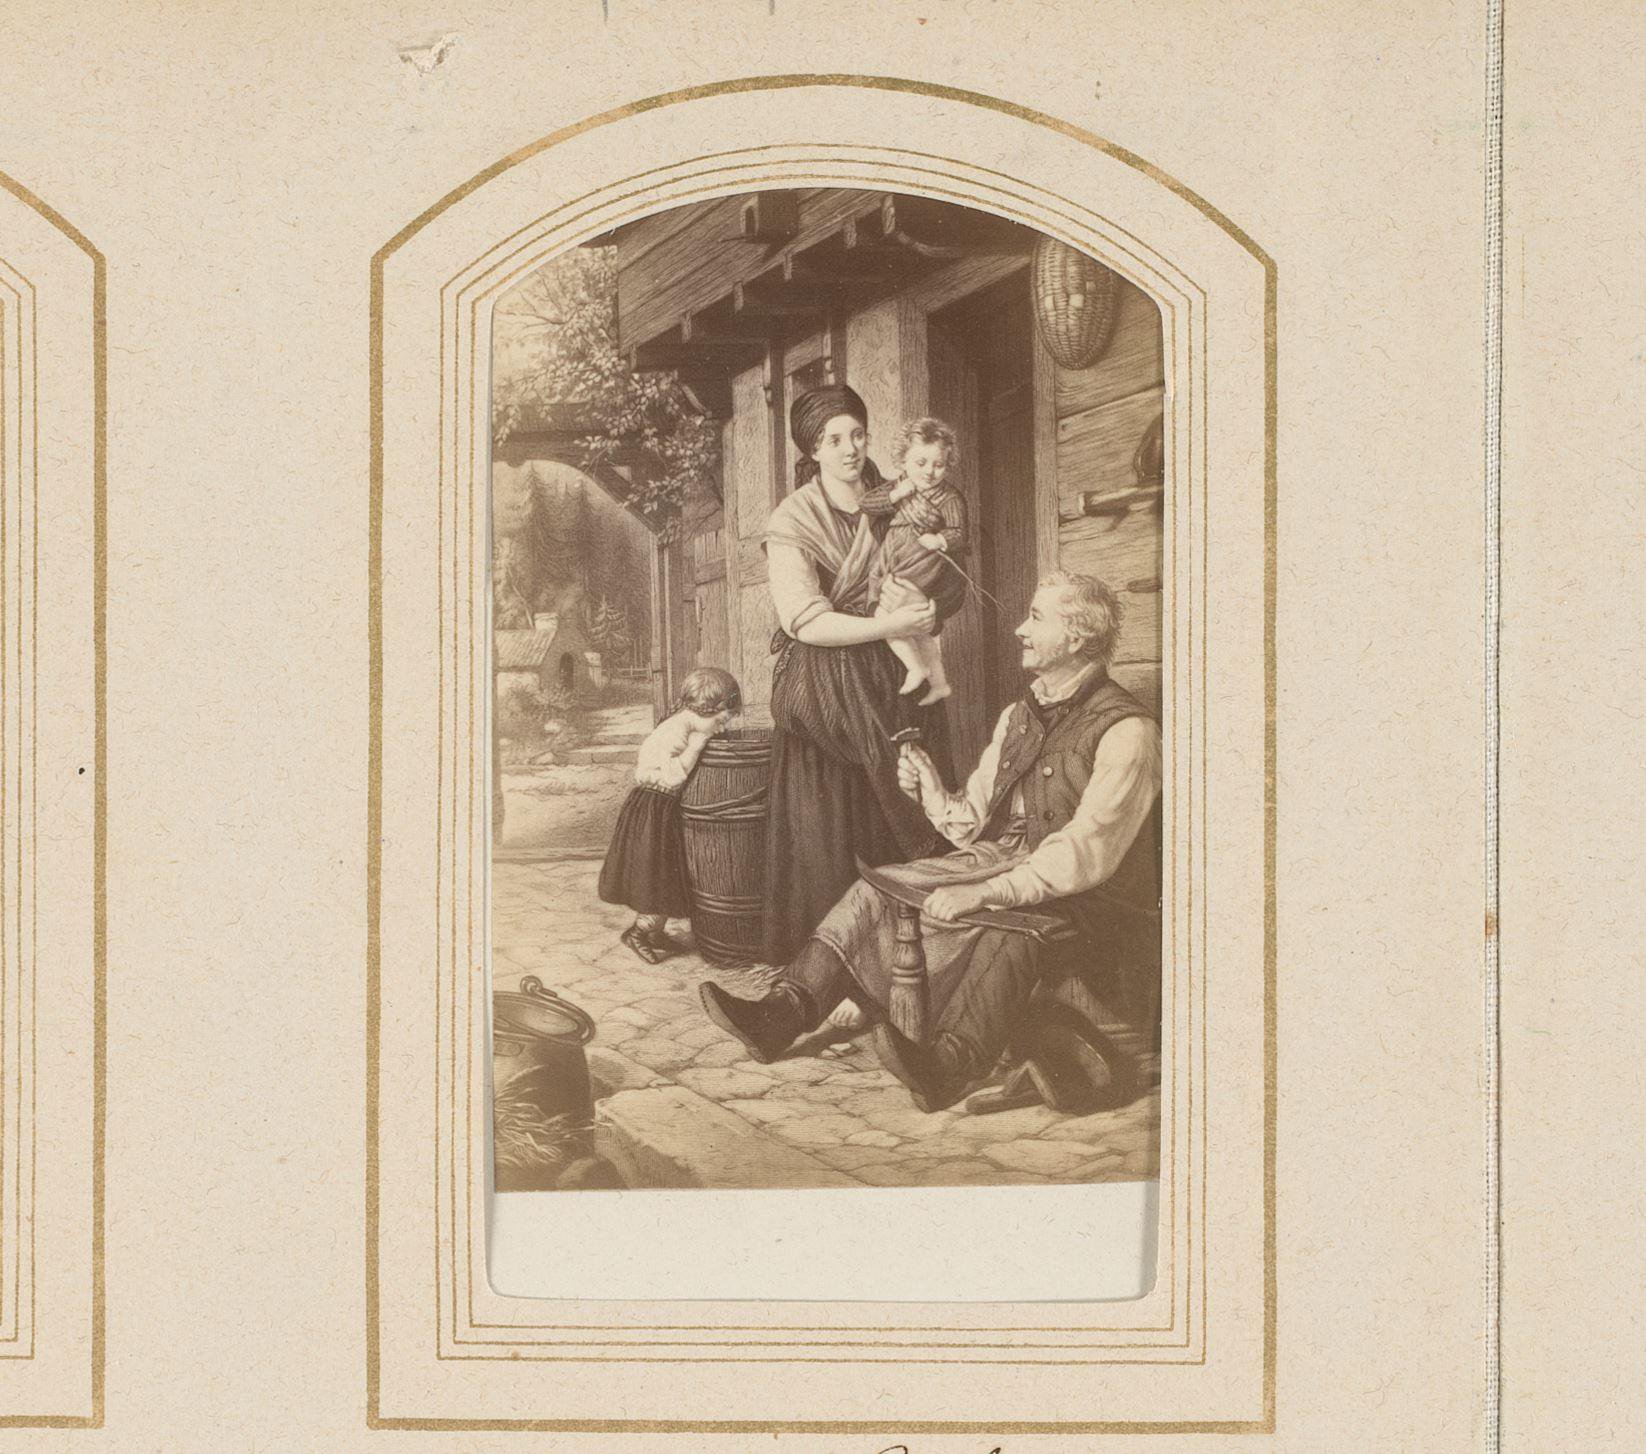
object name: carte de visite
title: Fotoreproductie van Die Abendstunde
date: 1870-1890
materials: cardboard, photographic support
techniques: albumen print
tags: parents with their children, façade (of house or building), painting, drawing and the graphic arts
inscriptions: number: ‘2764’, annotation: ‘Abendstunde’